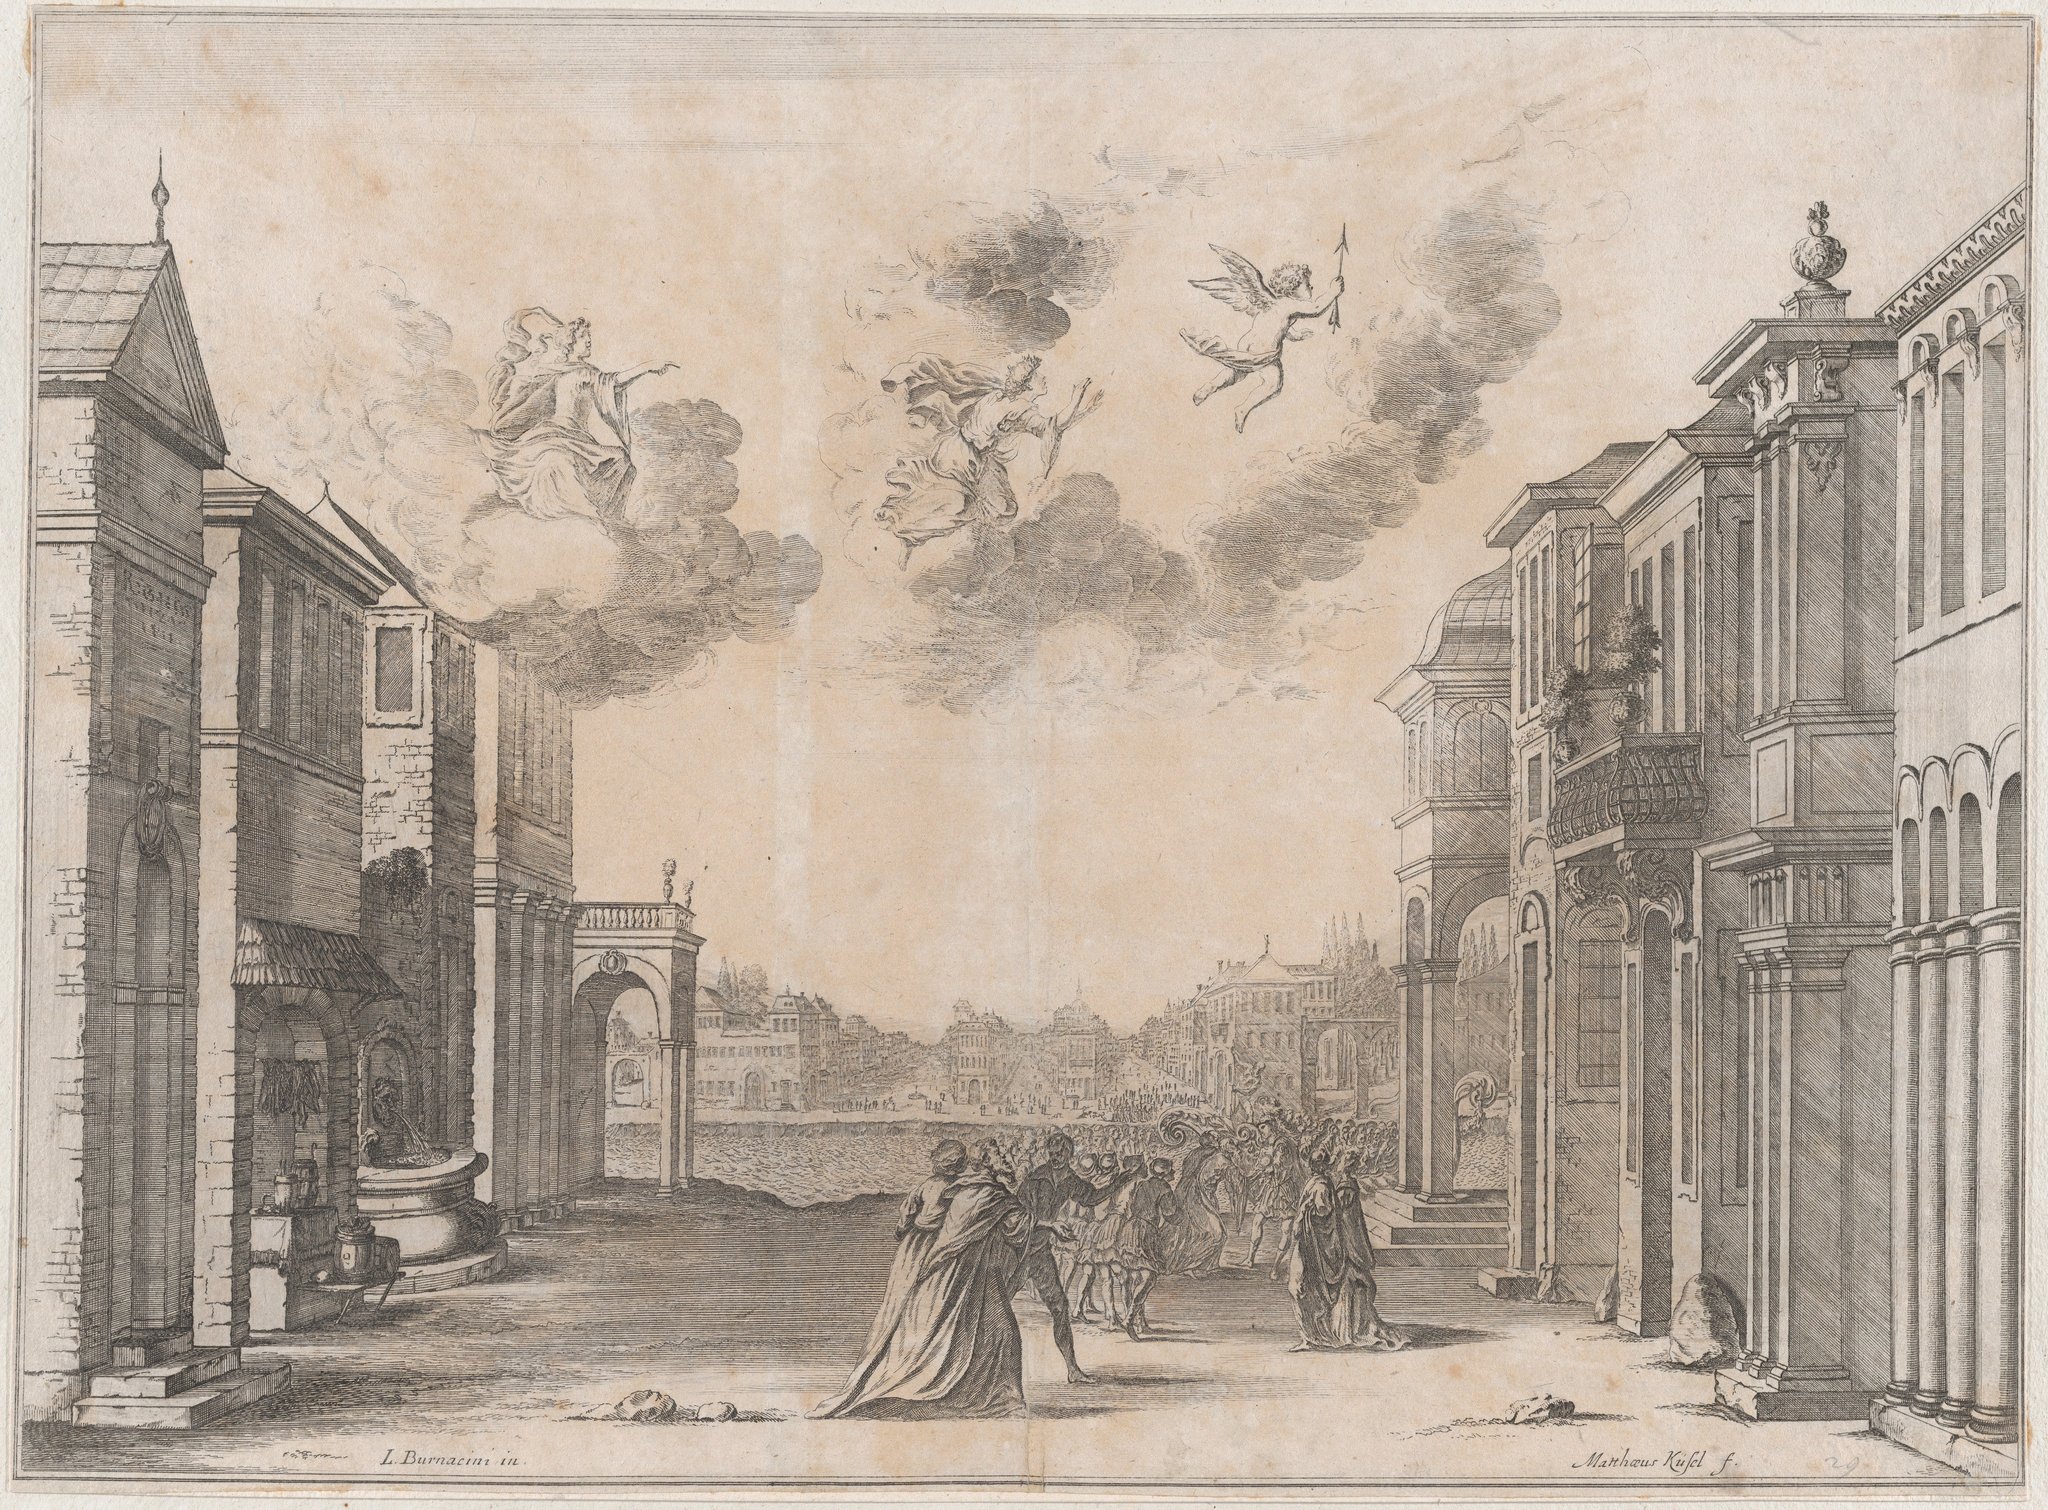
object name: print, fete, ornament architecture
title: Figures gathered at a seaport as a ship arrives; set design from 'Il Fuoco Eterno'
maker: mathäus küsel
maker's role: artist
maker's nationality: german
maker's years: 1621-1682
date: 1674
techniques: etching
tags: opera,stage design